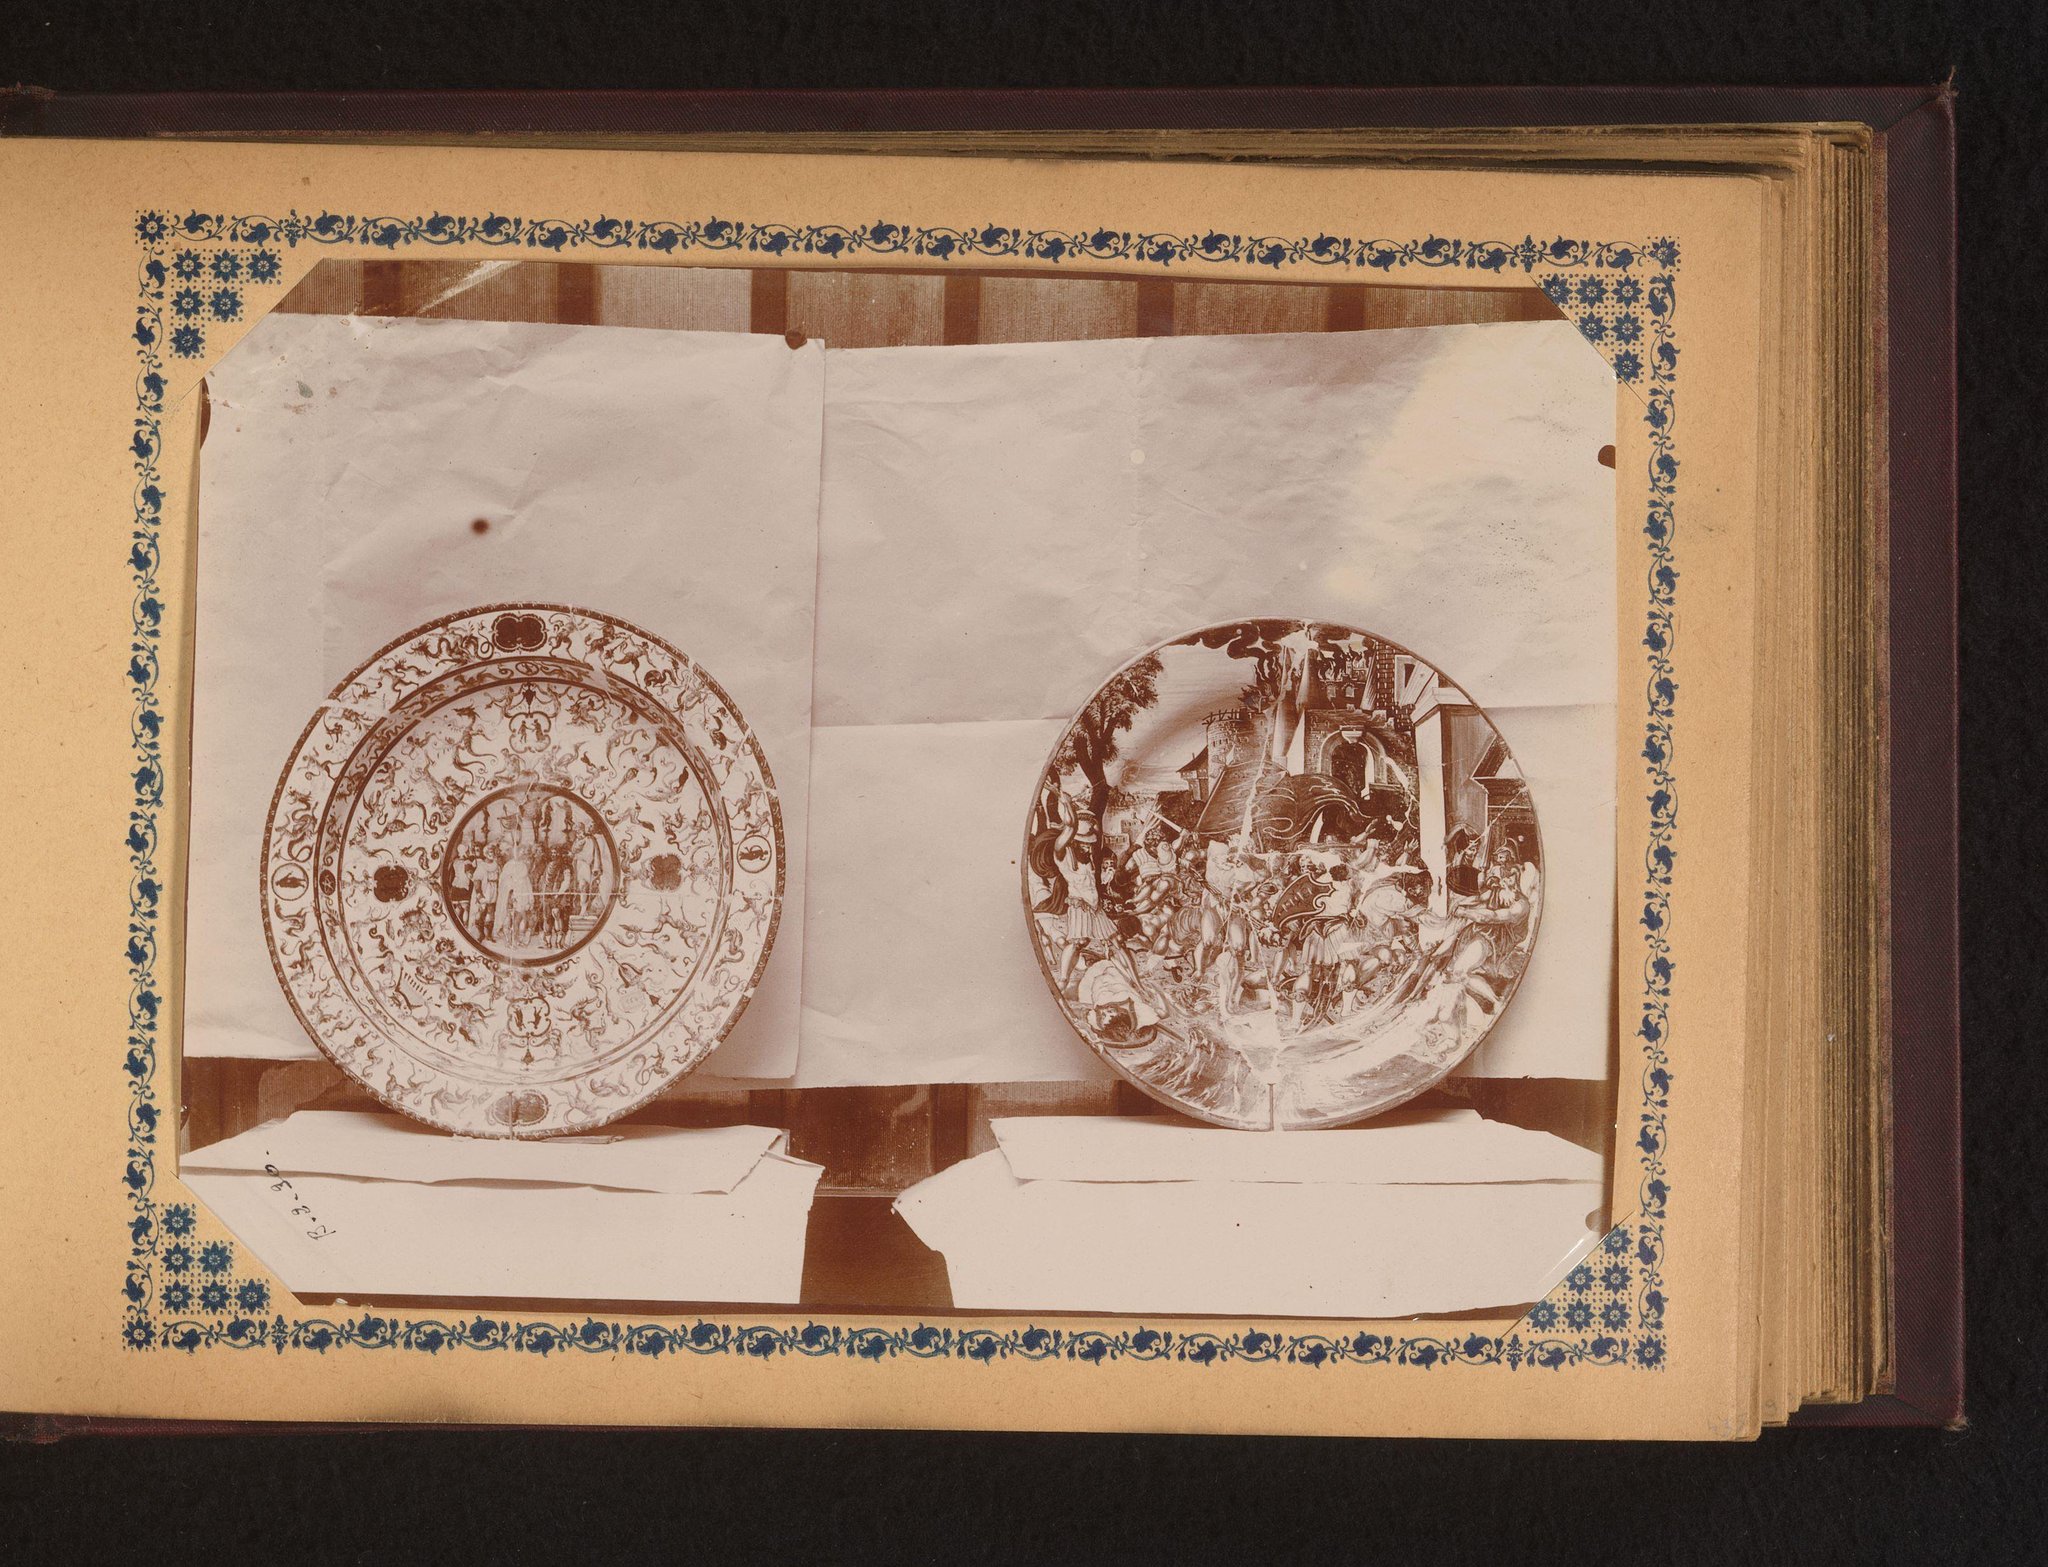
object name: album leaf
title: Twee borden beschilderd met voorstellingen en mythologische dieren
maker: Anonymous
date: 1880-1940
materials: cardboard, photographic support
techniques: gelatin silver print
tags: fabulous animals (sometimes wrongly called 'grotesques'); 'mostri' (ripa), dish, plate, saucer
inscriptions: number: ‘B. 2. 30’